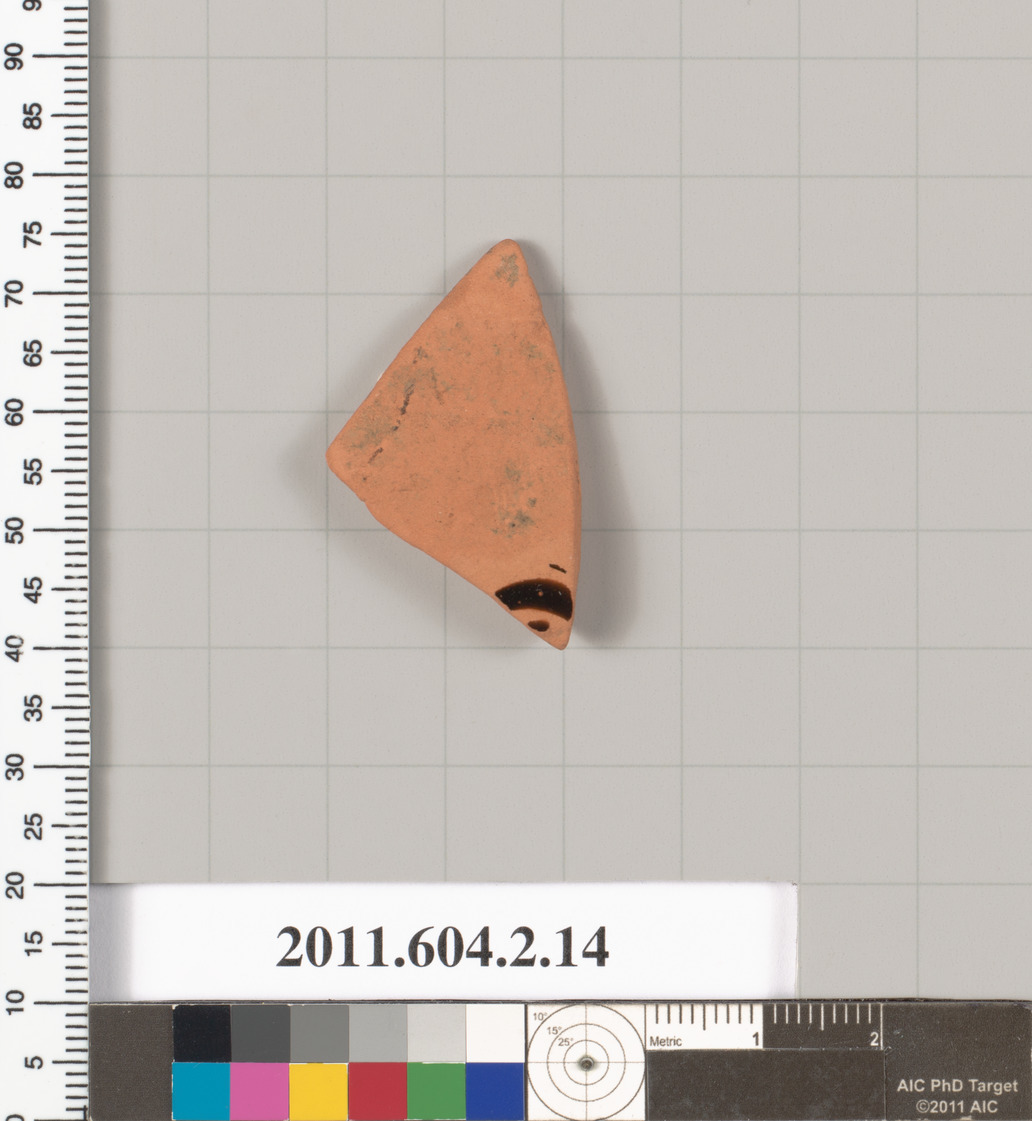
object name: neck amphora fragment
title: Terracotta fragment of a neck-amphora (jar)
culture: greek, attic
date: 475-451 BCE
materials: terracotta